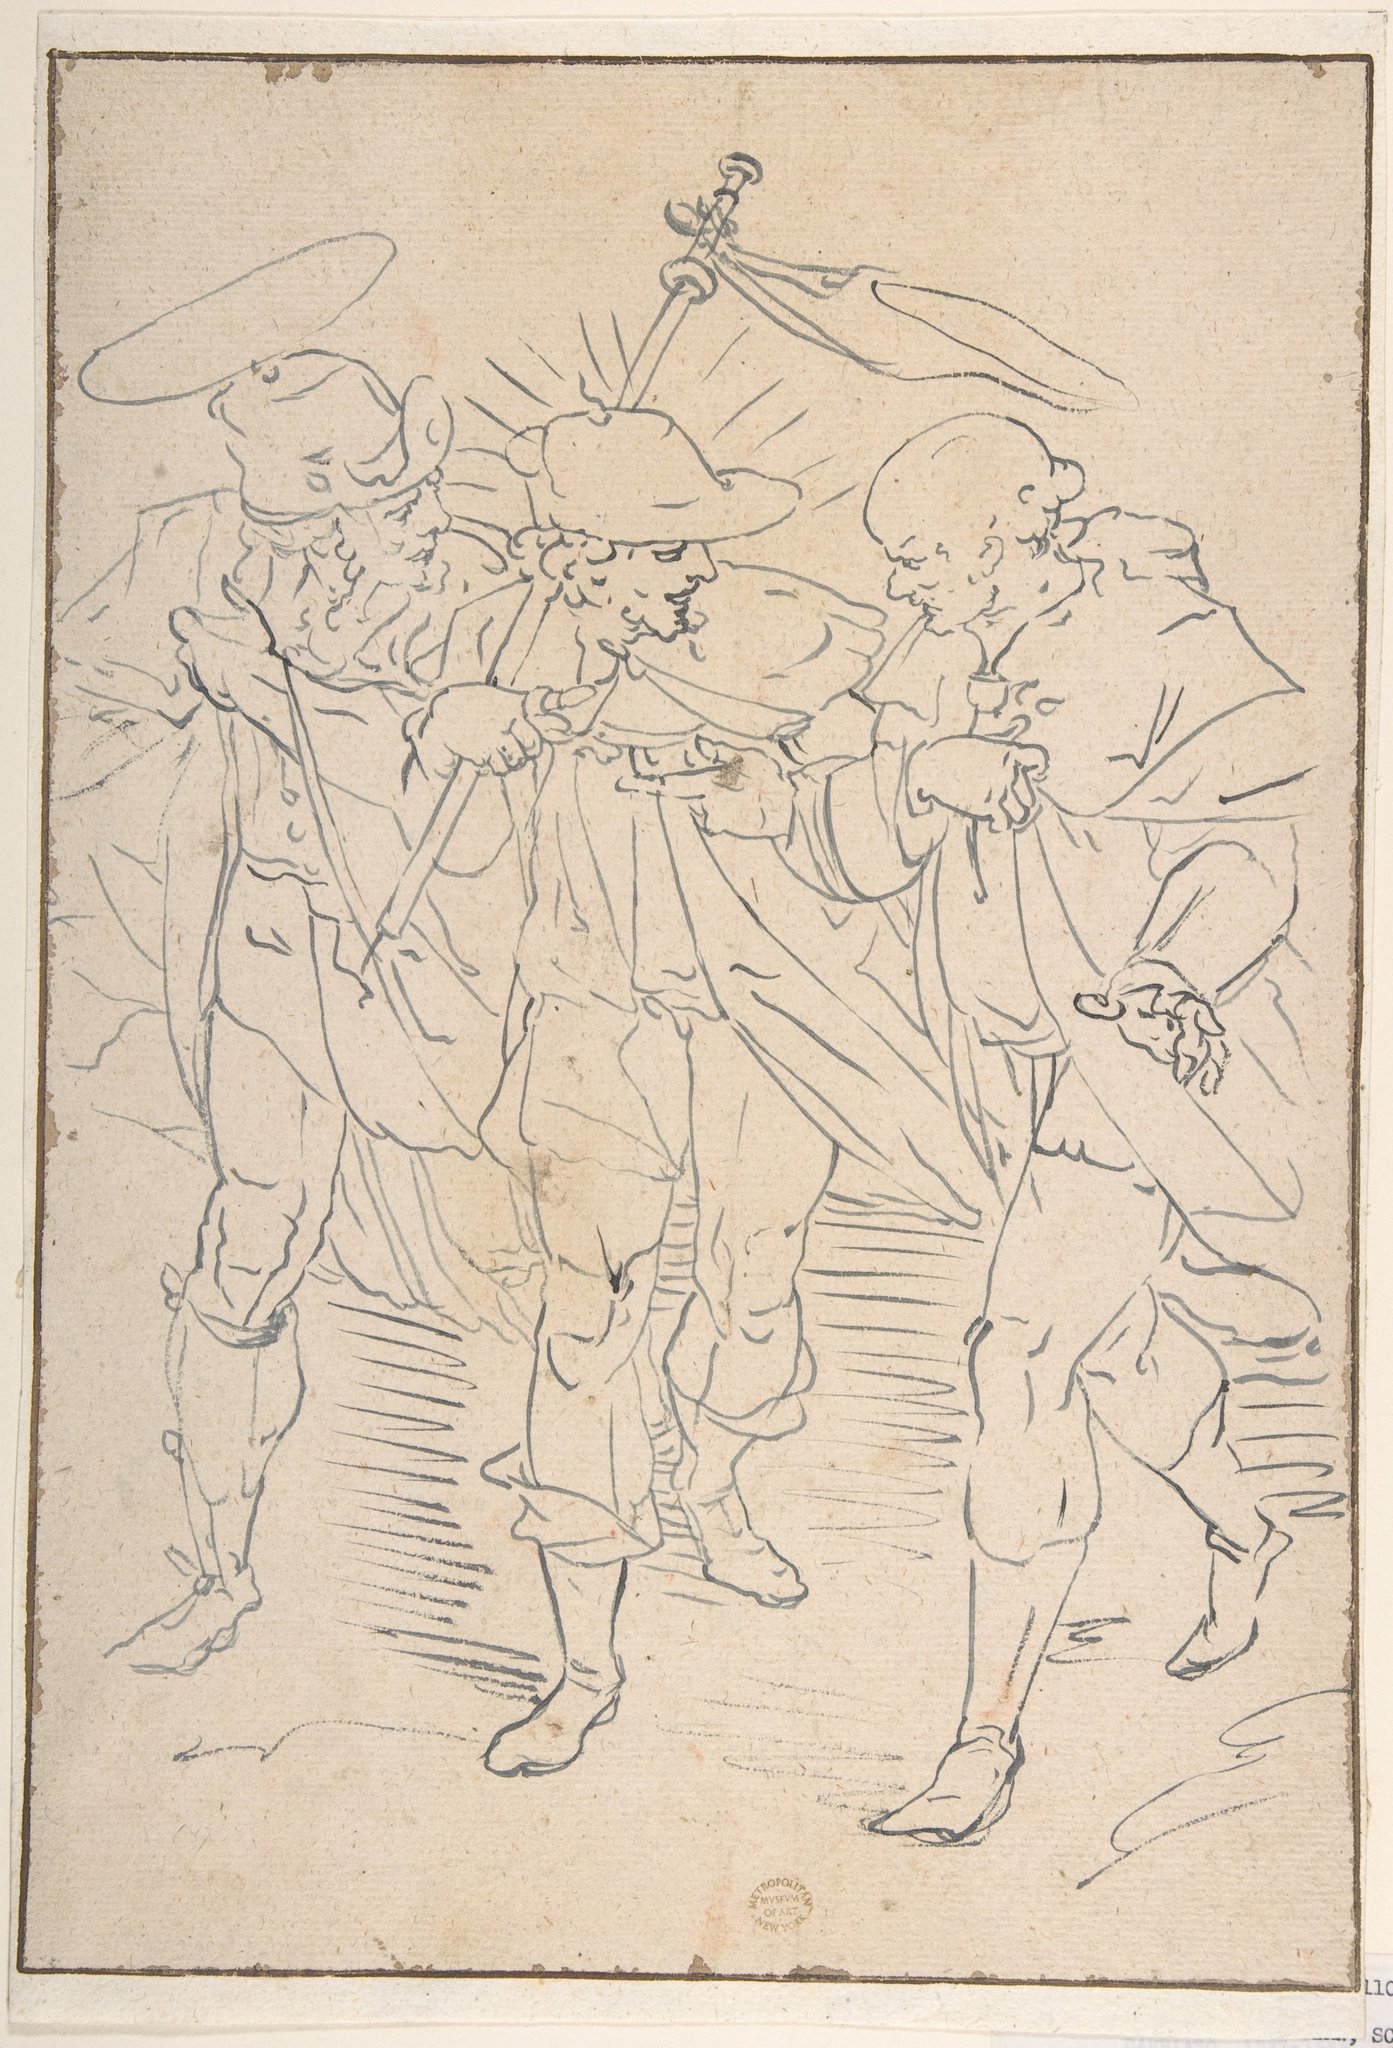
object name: drawing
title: The Way to Emmaus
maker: luca cambiaso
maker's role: artist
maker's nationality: italian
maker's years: 1527-1585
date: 1527-1585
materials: ink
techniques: brush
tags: men,walking,flags